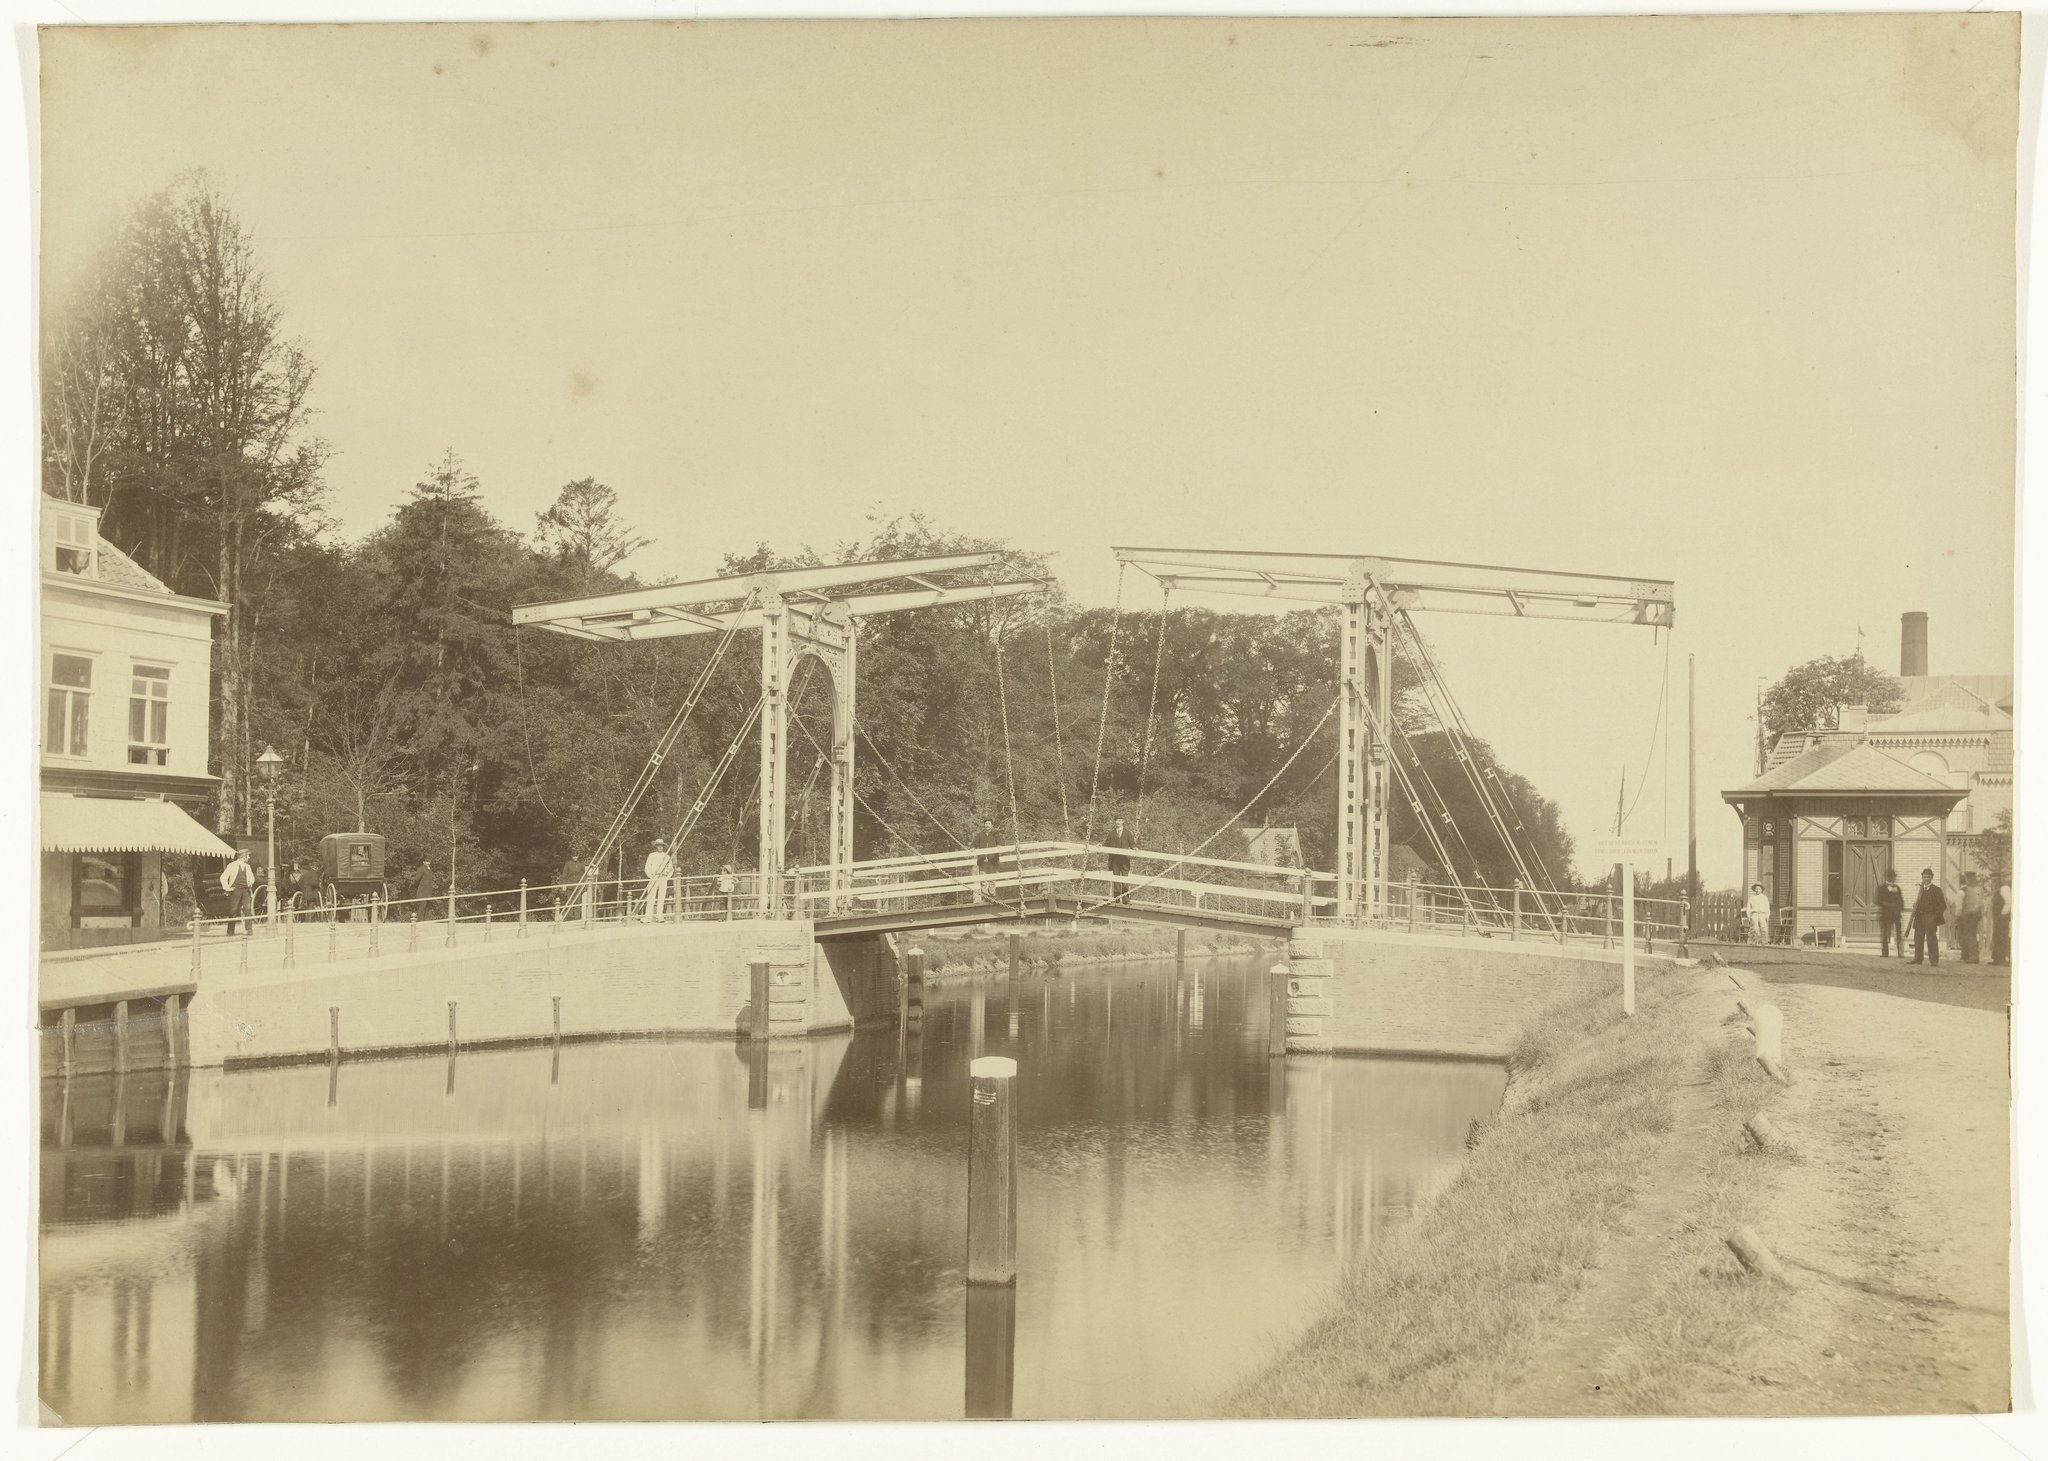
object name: photograph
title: Geestbrug te Voorburg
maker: henri de louw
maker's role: fotograaf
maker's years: 1851-1944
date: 1806-1895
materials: cardboard, photographic support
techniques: albumen print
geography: the hague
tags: bridge in city across river, canal, etc.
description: Zie RP-F-1996-111: exemplaar gedateerd. Zie RP-F-1996-111: exemplaar met naamsvermelding Henri de Louw.